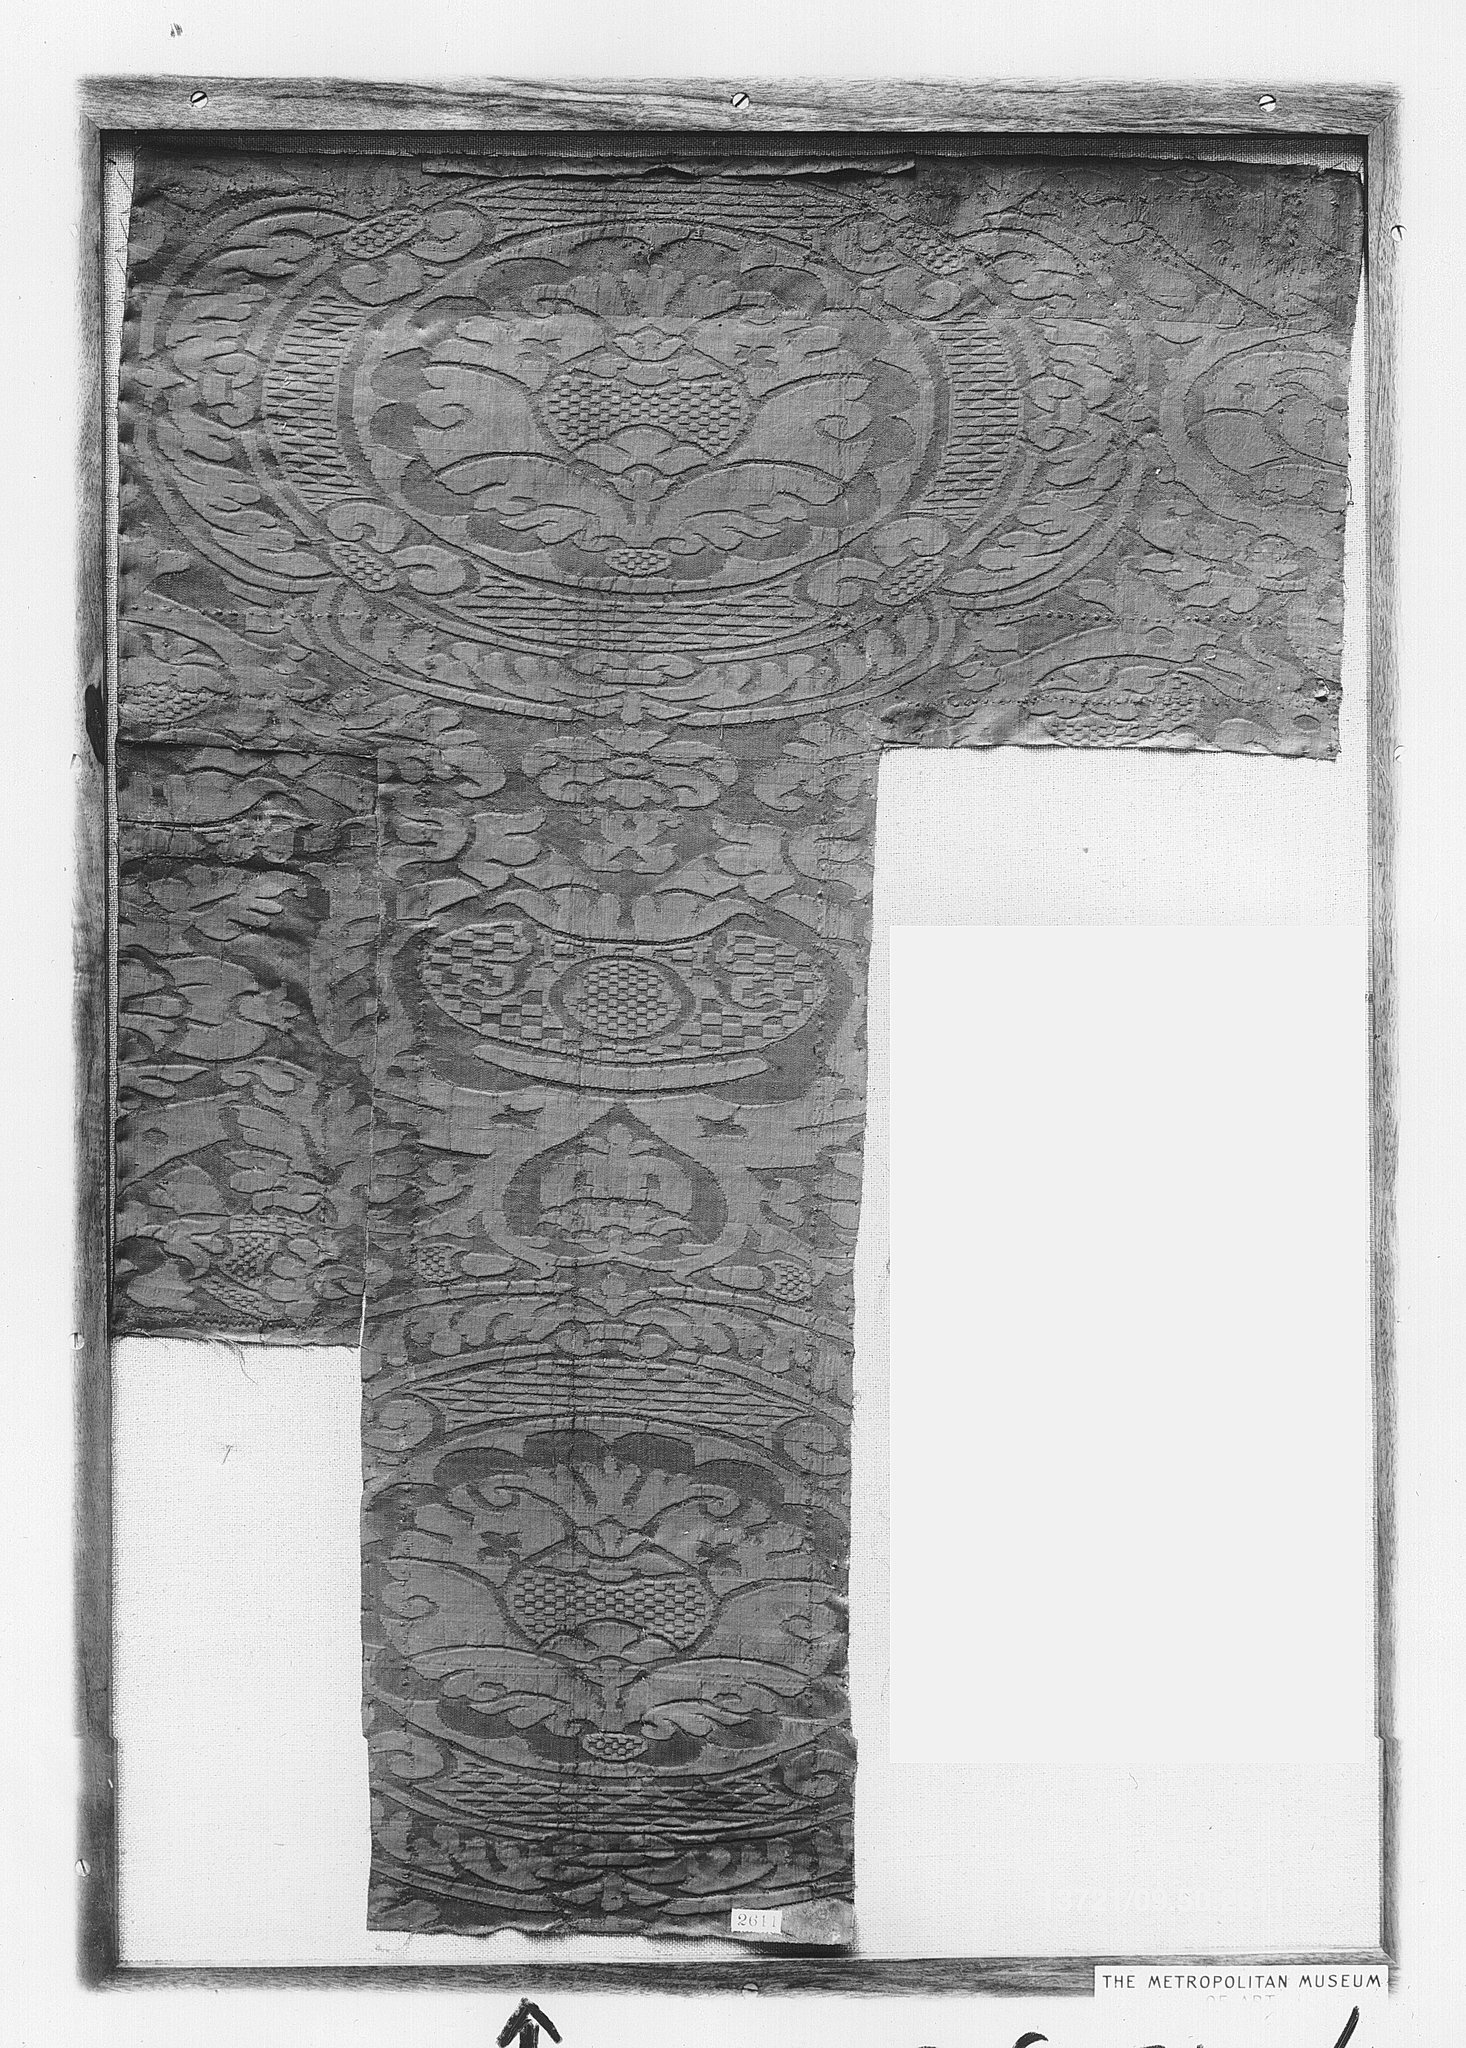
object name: piece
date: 1501-1600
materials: silk